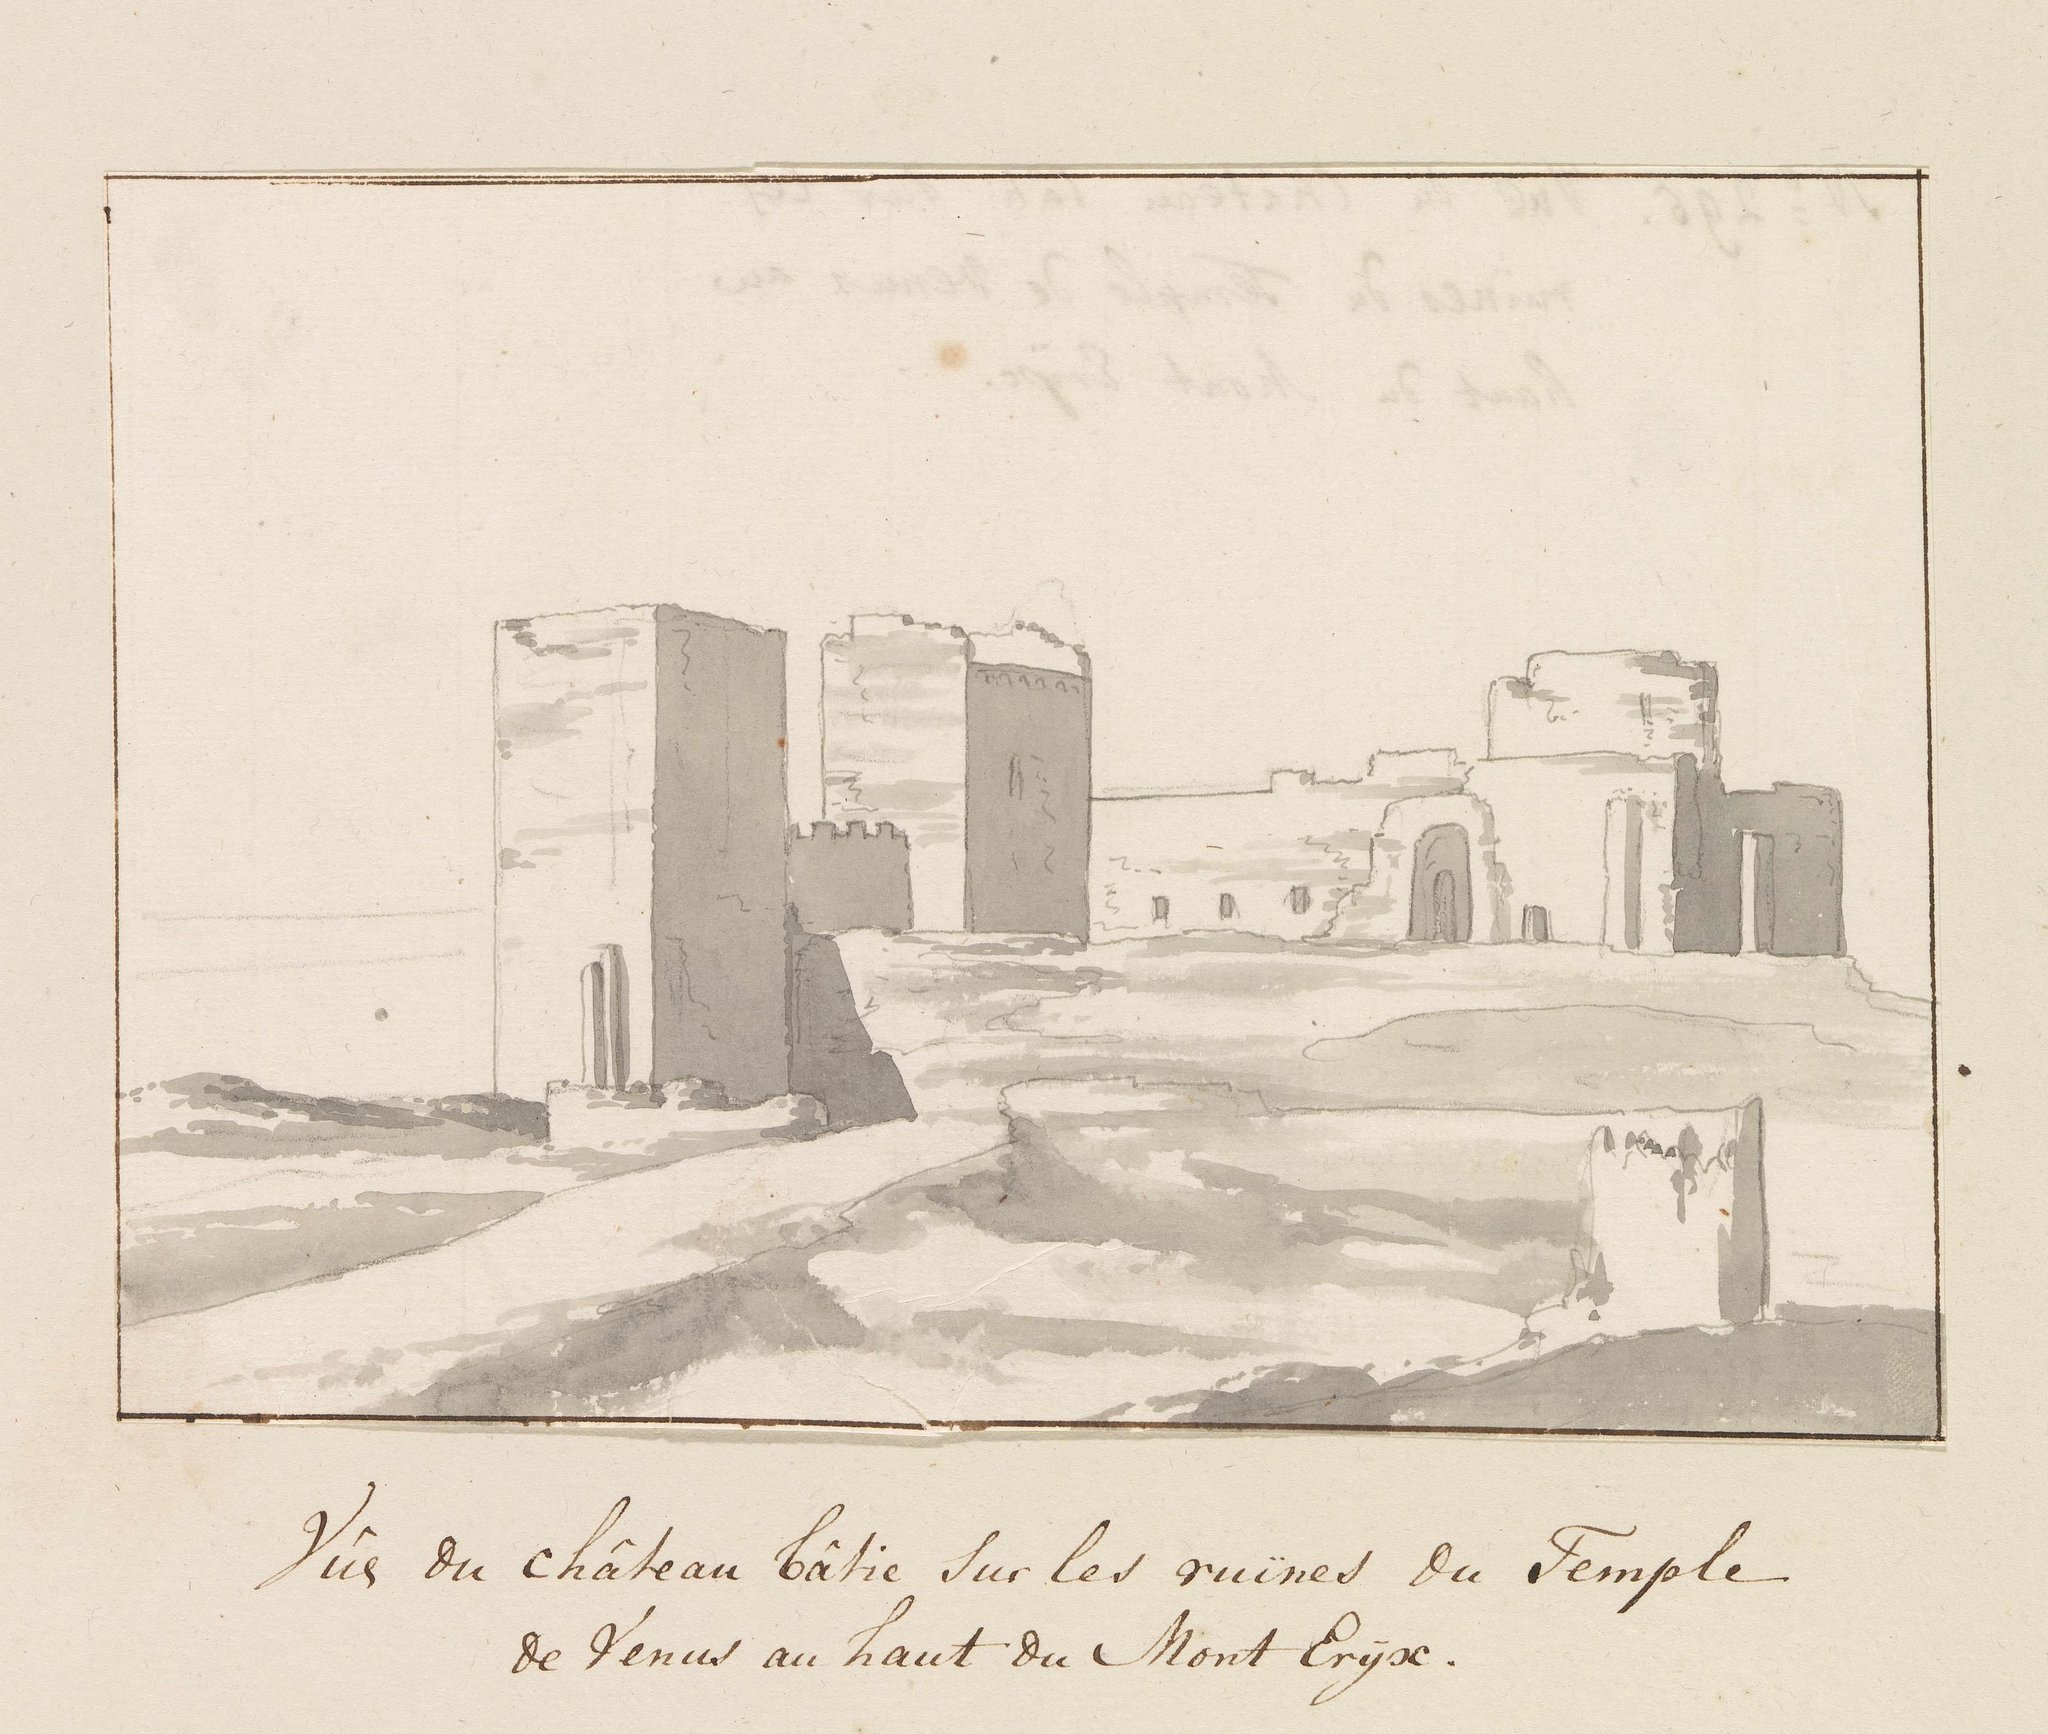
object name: drawing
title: Voyage en Italie, en Sicile et à Malte - 1778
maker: louis ducros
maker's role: draughtsman, print maker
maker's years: 1748-1810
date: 1778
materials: chalk, paper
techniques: brush, pen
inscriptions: inscription: ‘No 295 Vue du château bâtie sur les ruïnes du Temple de Venus au haut du Mont Eryx’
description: Tekening uit het album 'Voyage en Italie, en Sicile et à Malte', 1778.